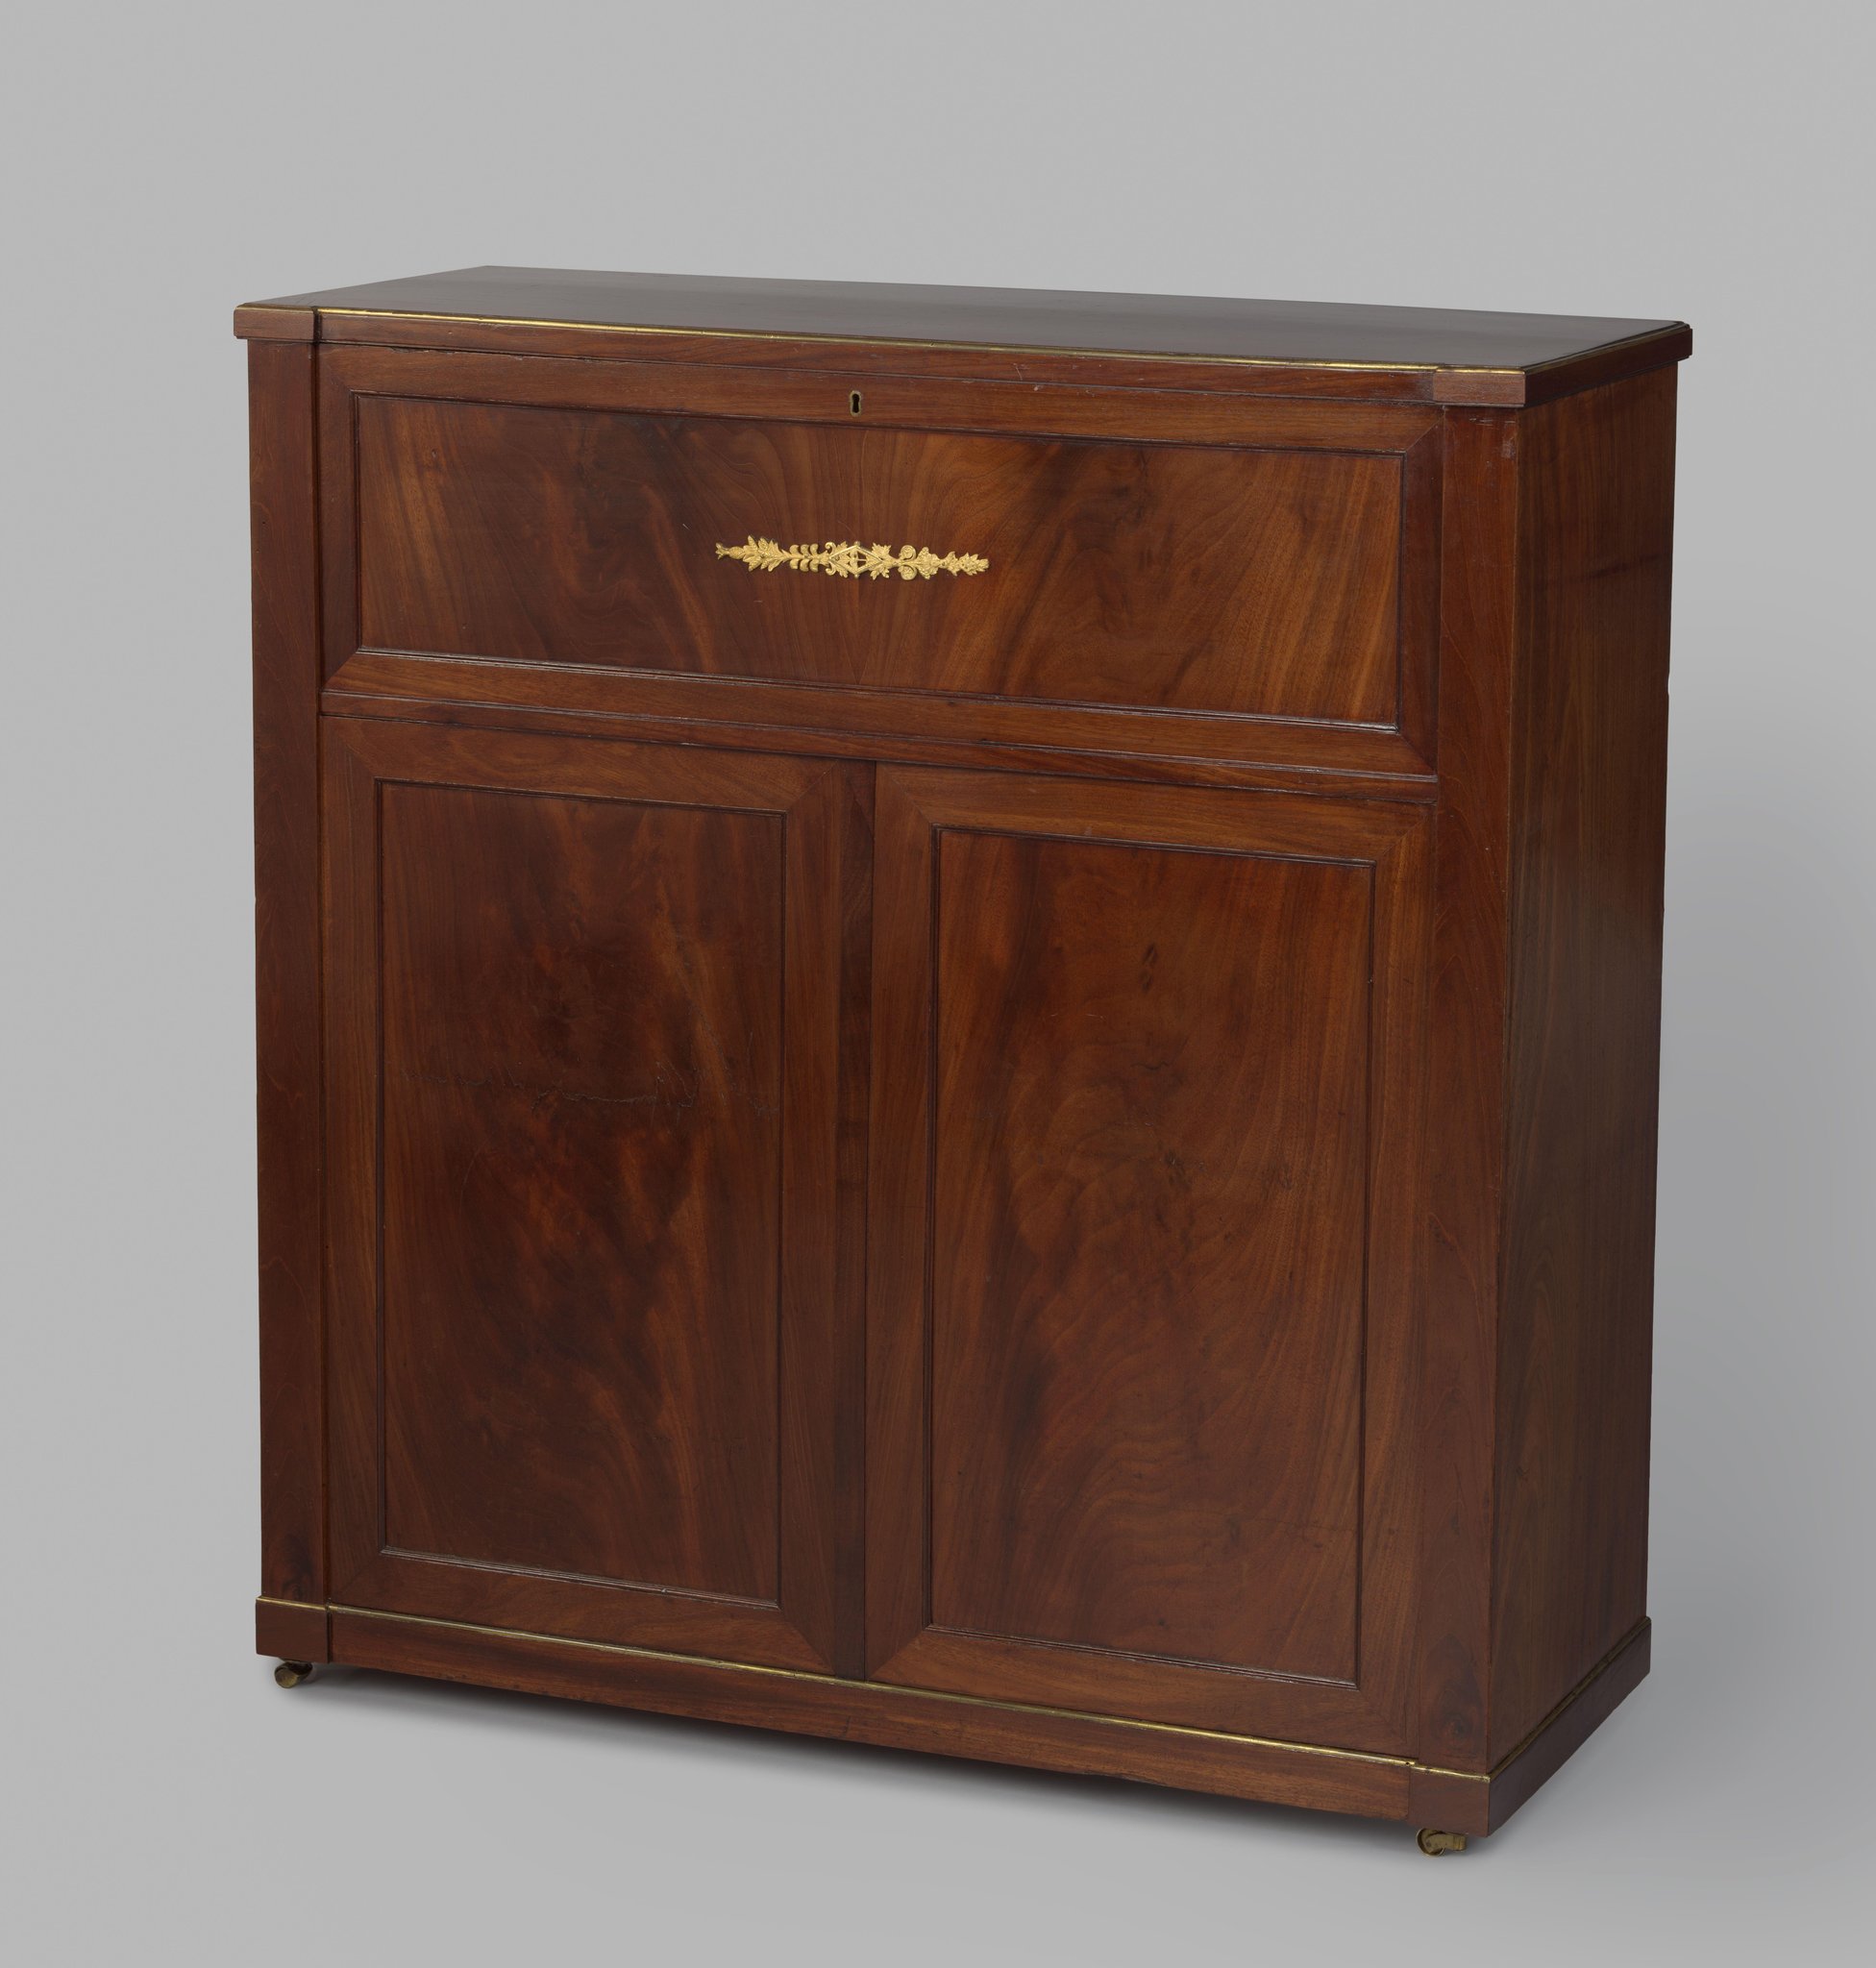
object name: musical instrument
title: Cabinet with barrels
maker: Anonymous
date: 1815-1825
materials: wood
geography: amsterdam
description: Rollenkast van eikenhout en mahonie. De blinde deuren zijn versierd met een lier, de klep met ornament. Langs plint en bovenblad een koperen bagetje. Rollenkast hoort bij saloncylinderorgel in de vorm van een secretaire (BK-NM-14353-A).